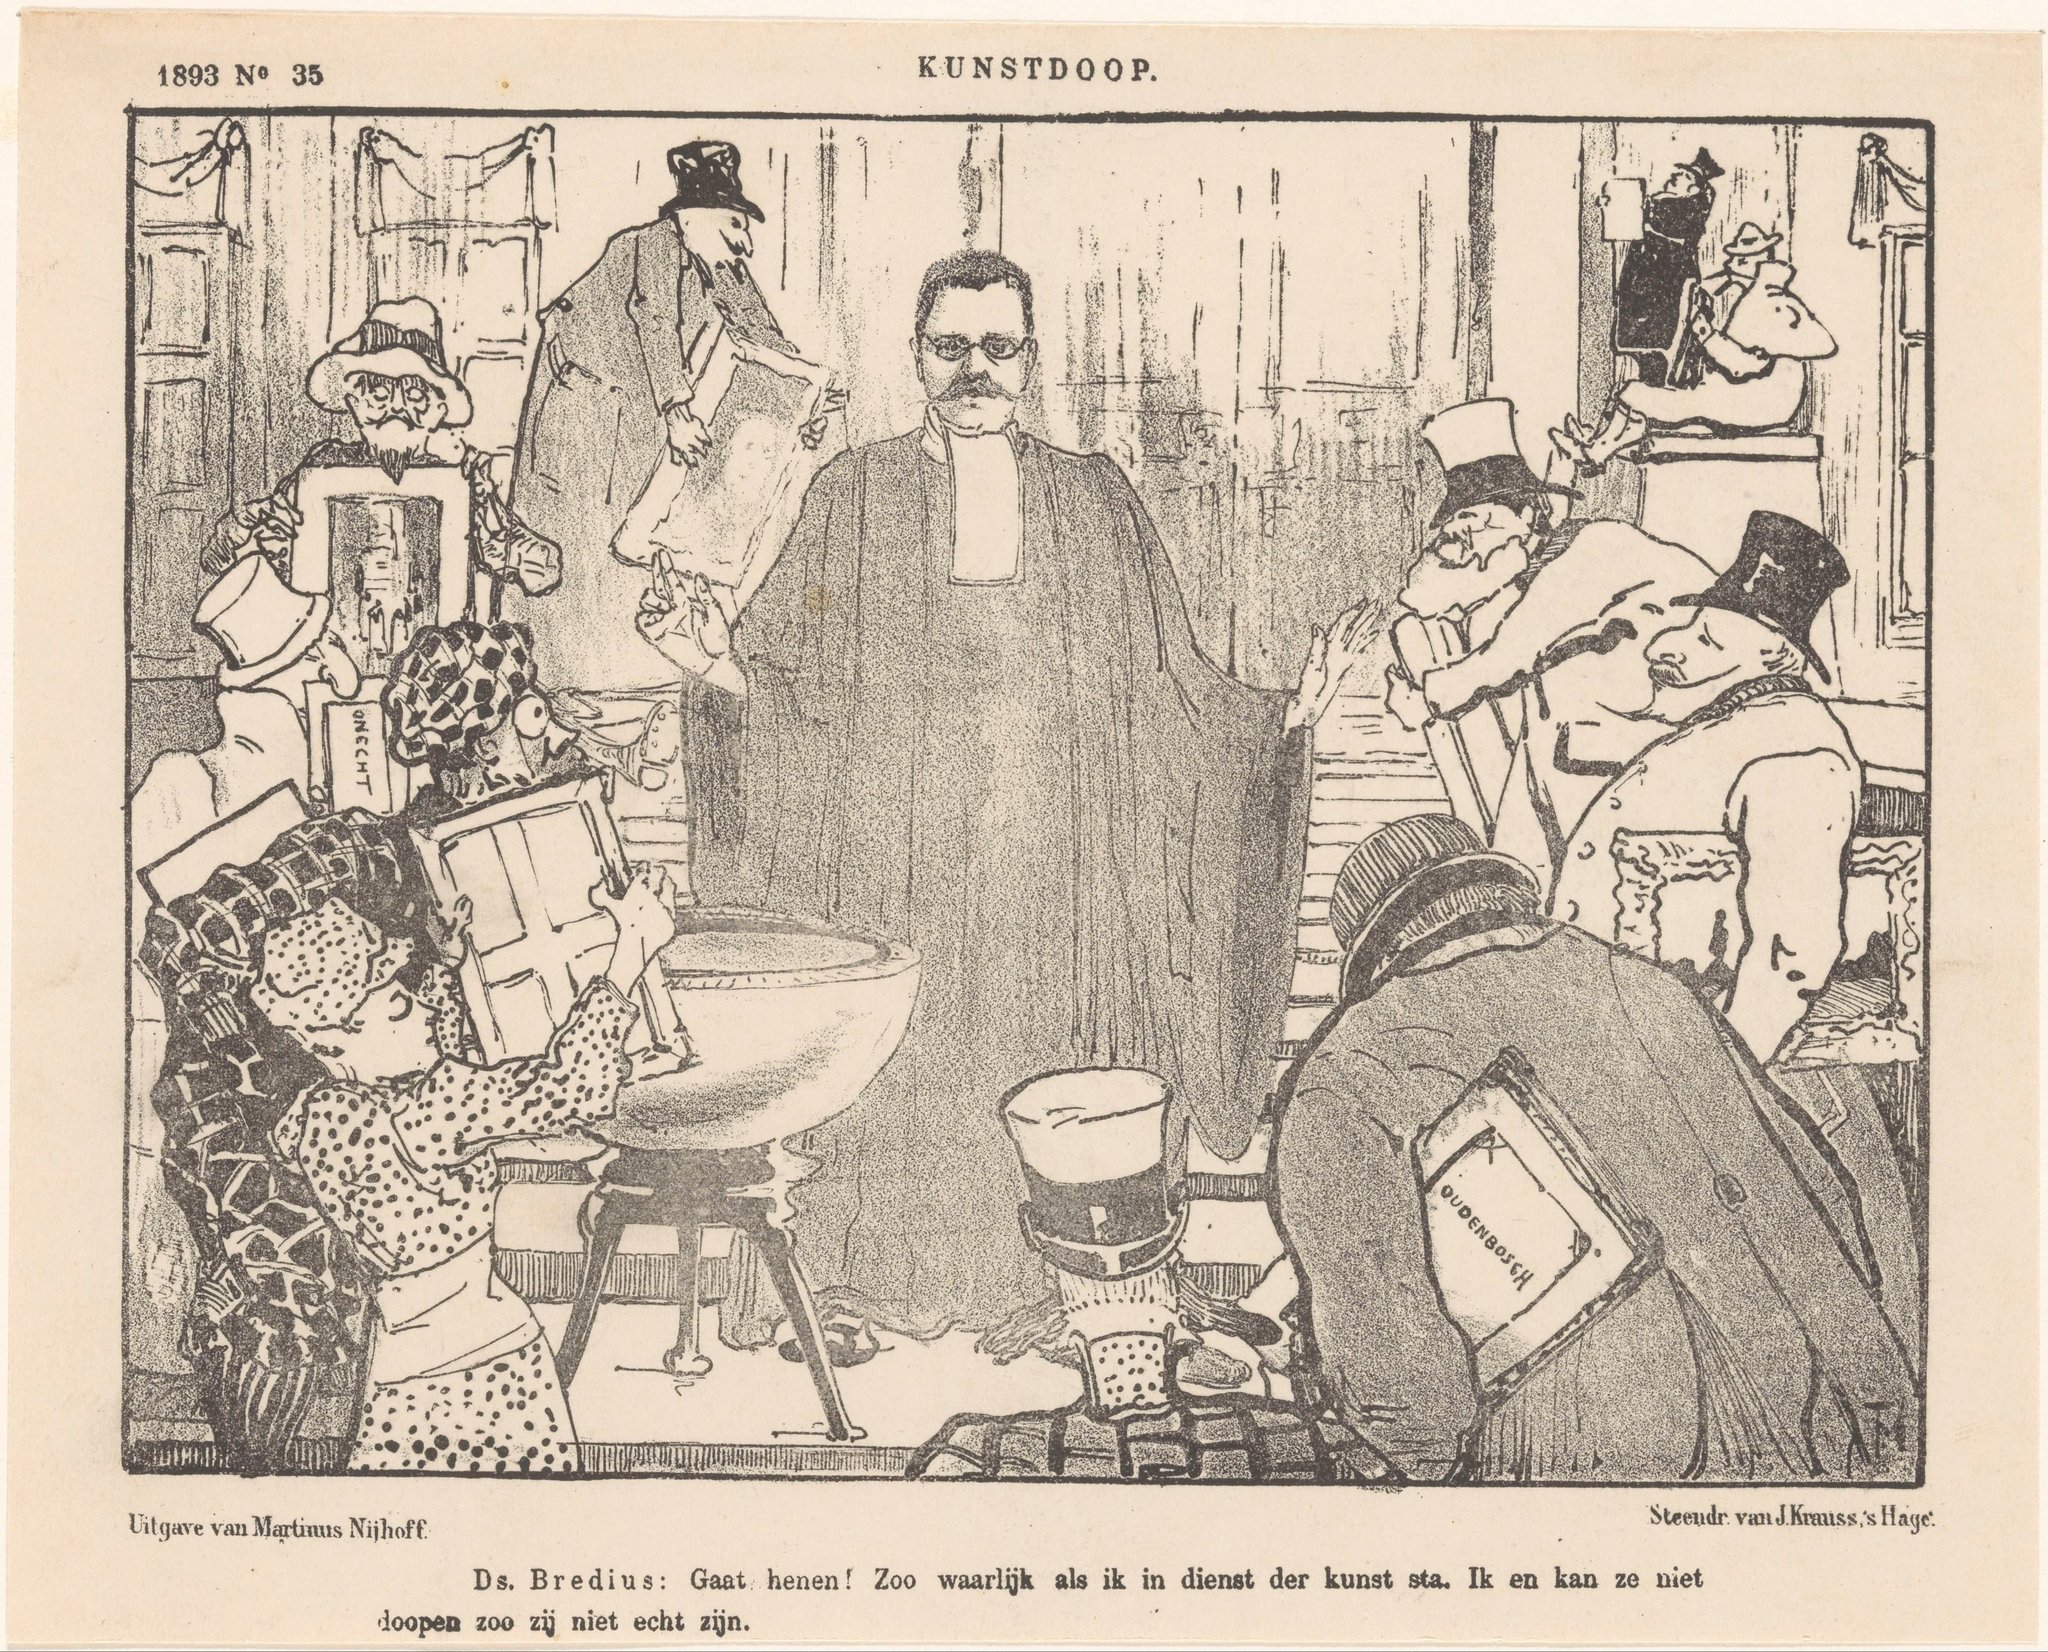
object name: cartoon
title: Spotprent over de kunsthistoricus Abraham Bredius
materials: paper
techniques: letterpress printing, lithograph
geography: the hague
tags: baptismal font, picture, painting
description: Mensen brengen schilderijen naar een man in toga naast een doopvont.